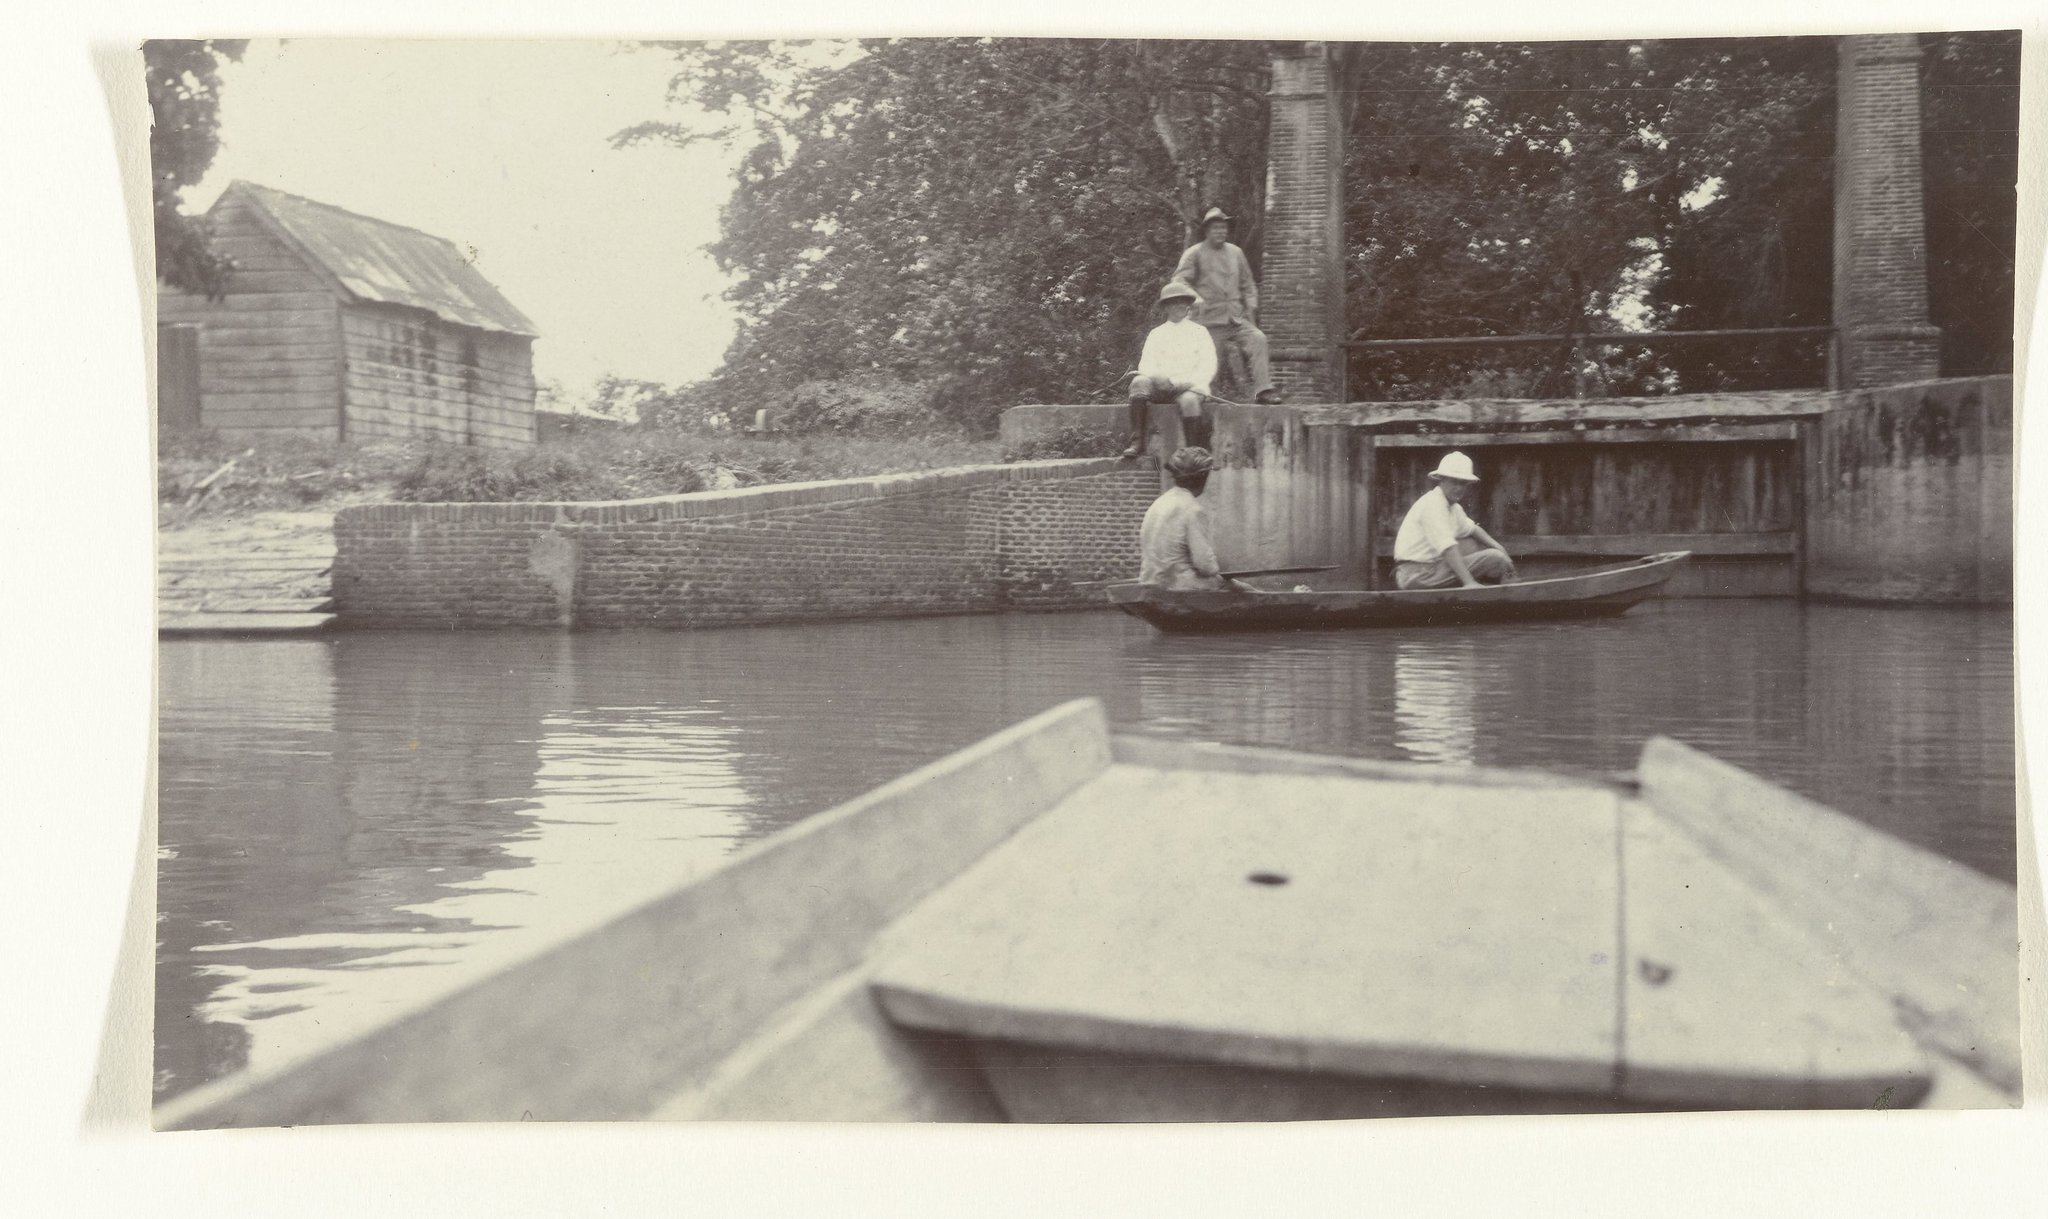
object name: photograph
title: Theodoor Brouwers en arbeiders bij sluis op plantage Accaribo te Suriname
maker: theodoor brouwers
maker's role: amateurfotograaf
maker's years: 1874-1932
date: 1916-1930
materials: photographic support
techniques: photography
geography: suriname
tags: amsterdam, theodoor brouwers, plantation, suriname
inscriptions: inscription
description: In de periode 1911-1932 woonde op plantage Accaribo in Suriname de familie Brouwers van wie de foto's afkomstig zijn. Rond 1910 vond Theodoor Brouwers werk op plantage Accaribo. In 1929 werd hij eigenaar van de plantage.